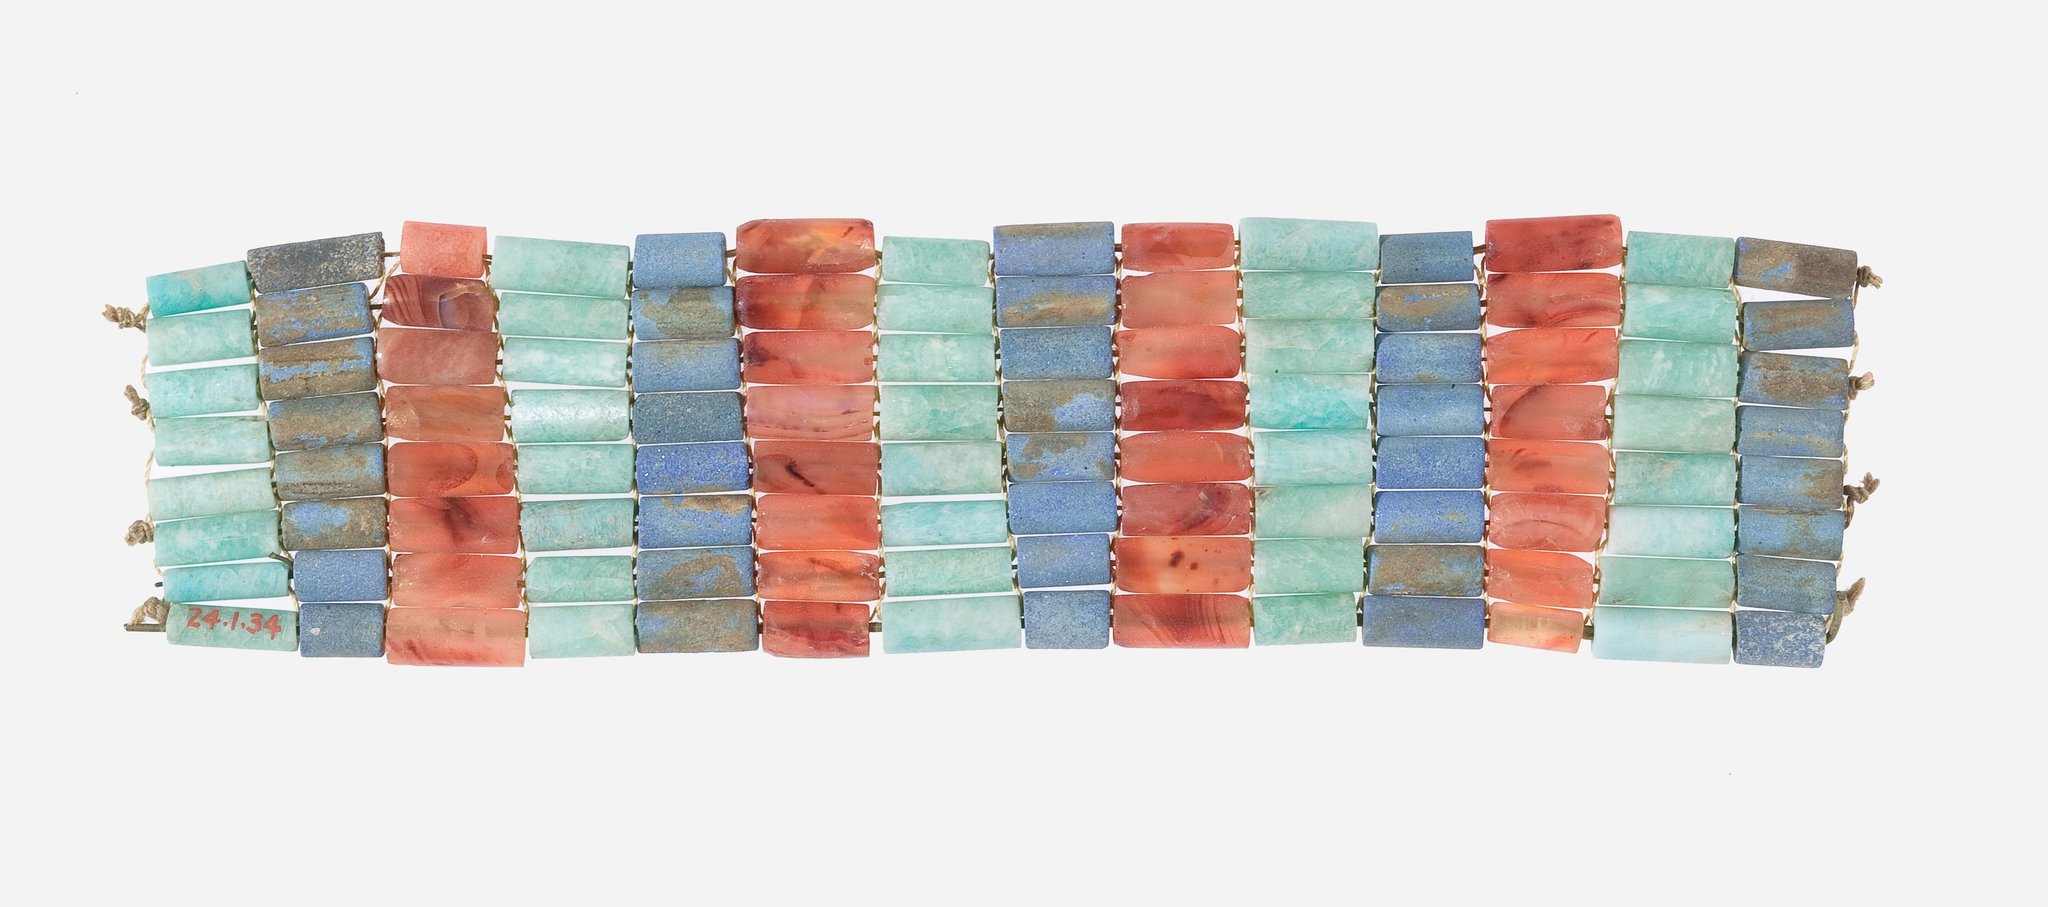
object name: bracelet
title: Bracelet of cylindrical beads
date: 1981-1802 BCE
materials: gemstone, paste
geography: egypt